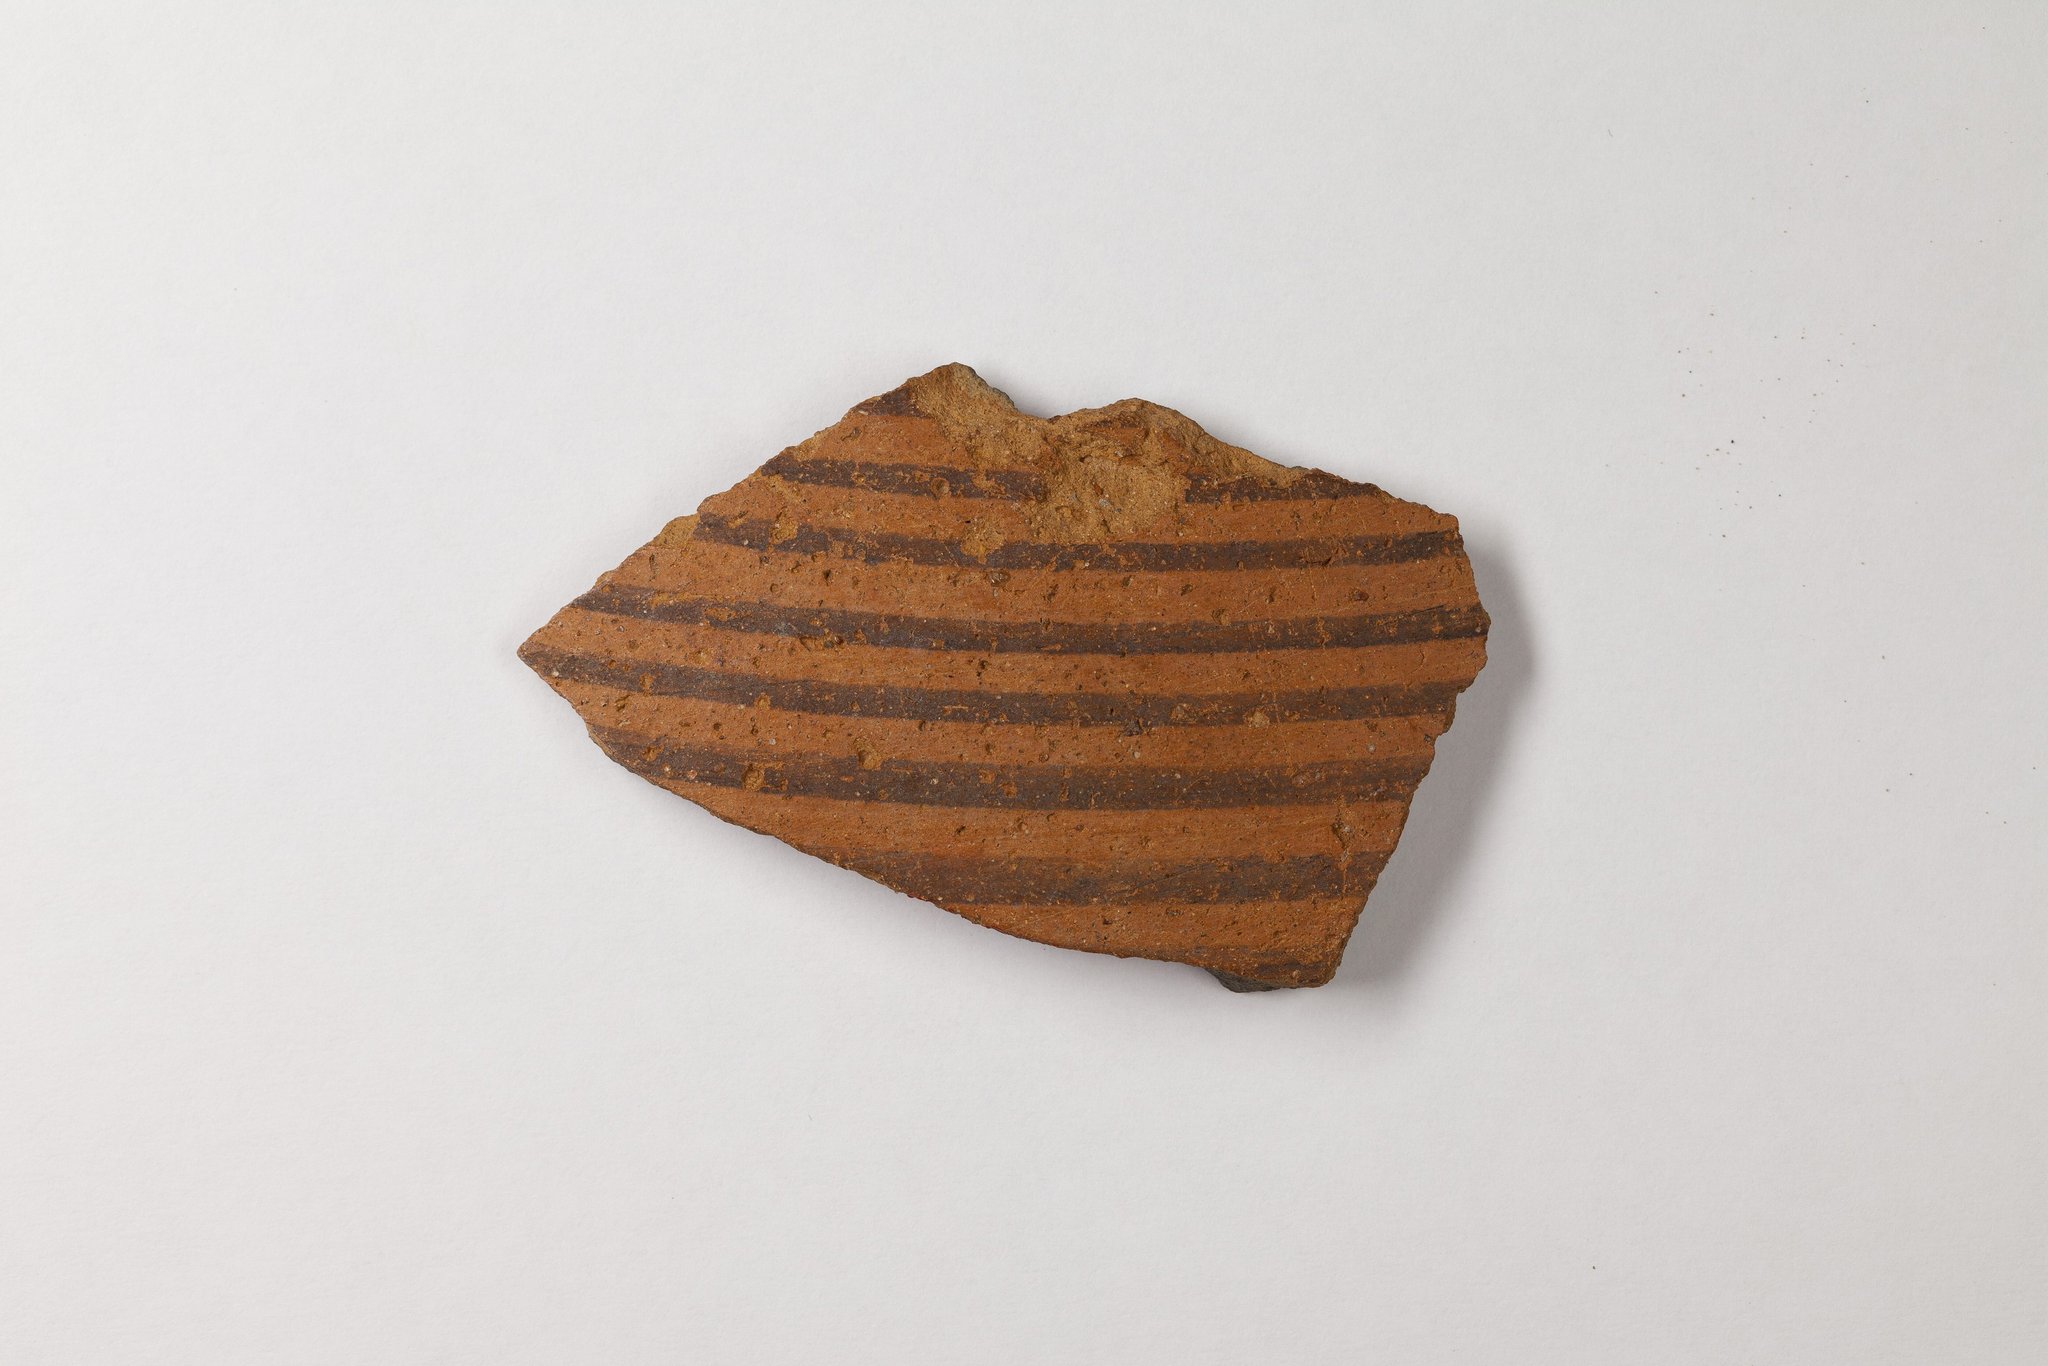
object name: bowl sherd, aegean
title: Bowl sherd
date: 1981-1640 BCE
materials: pottery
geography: egypt